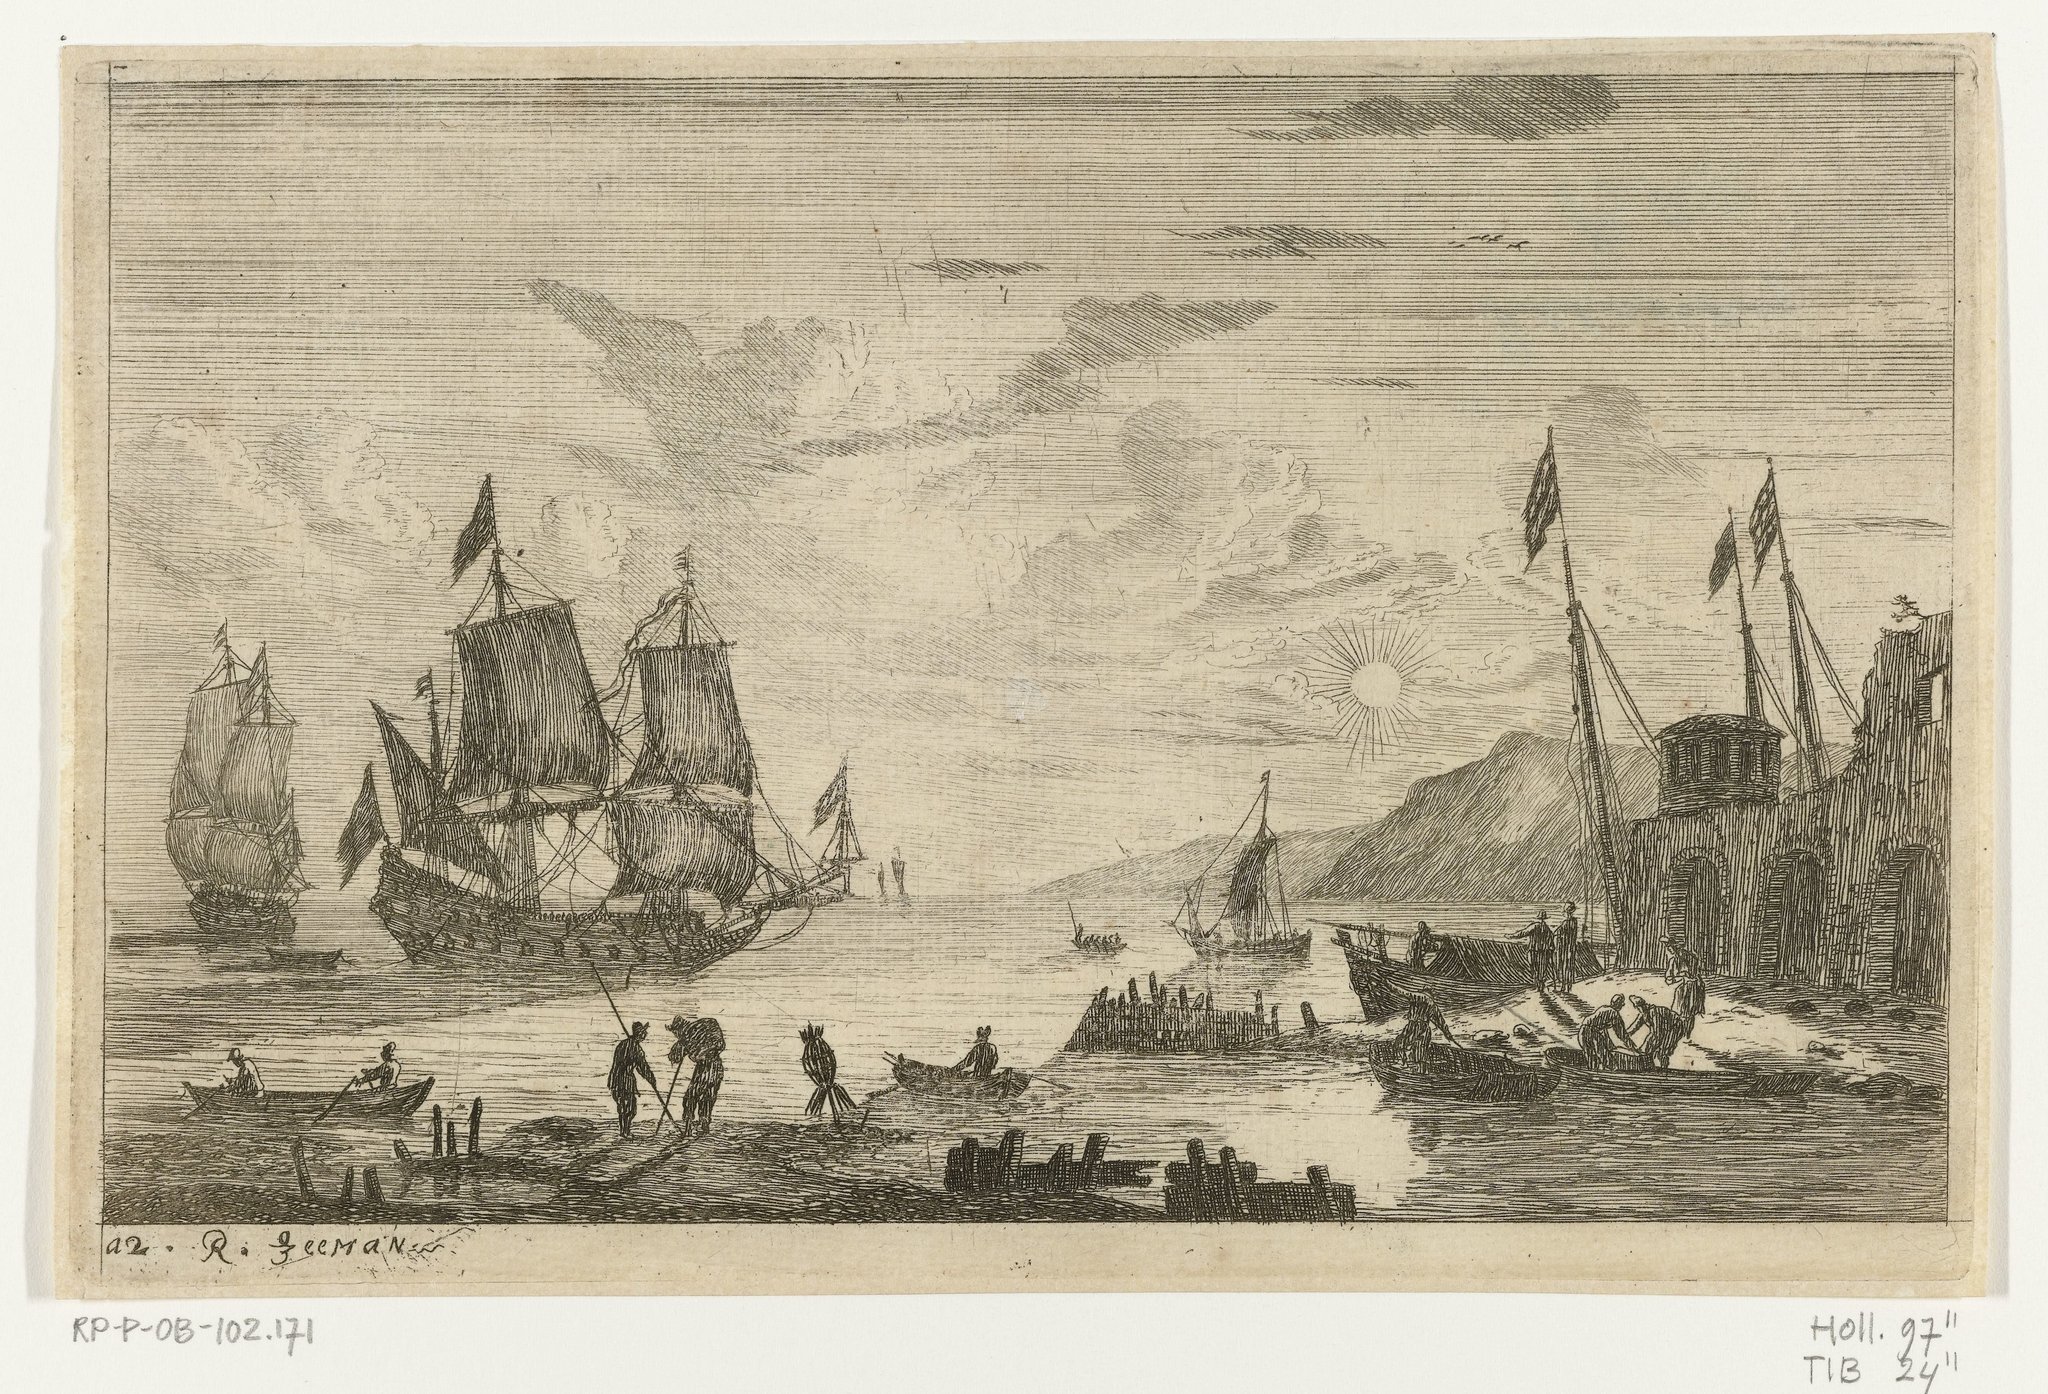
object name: print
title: Quelqe port dee Meer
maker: reinier nooms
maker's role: draughtsman, painter, print maker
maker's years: 1623-1664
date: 1656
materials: paper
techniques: etching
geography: netherlands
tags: harbour, gulf, bay, sailing-ship, sailing-boat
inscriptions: collector's mark: Lugt 2228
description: Havenscène met twee grote Nederlandse zeilschepen bij een ondergaande zon.